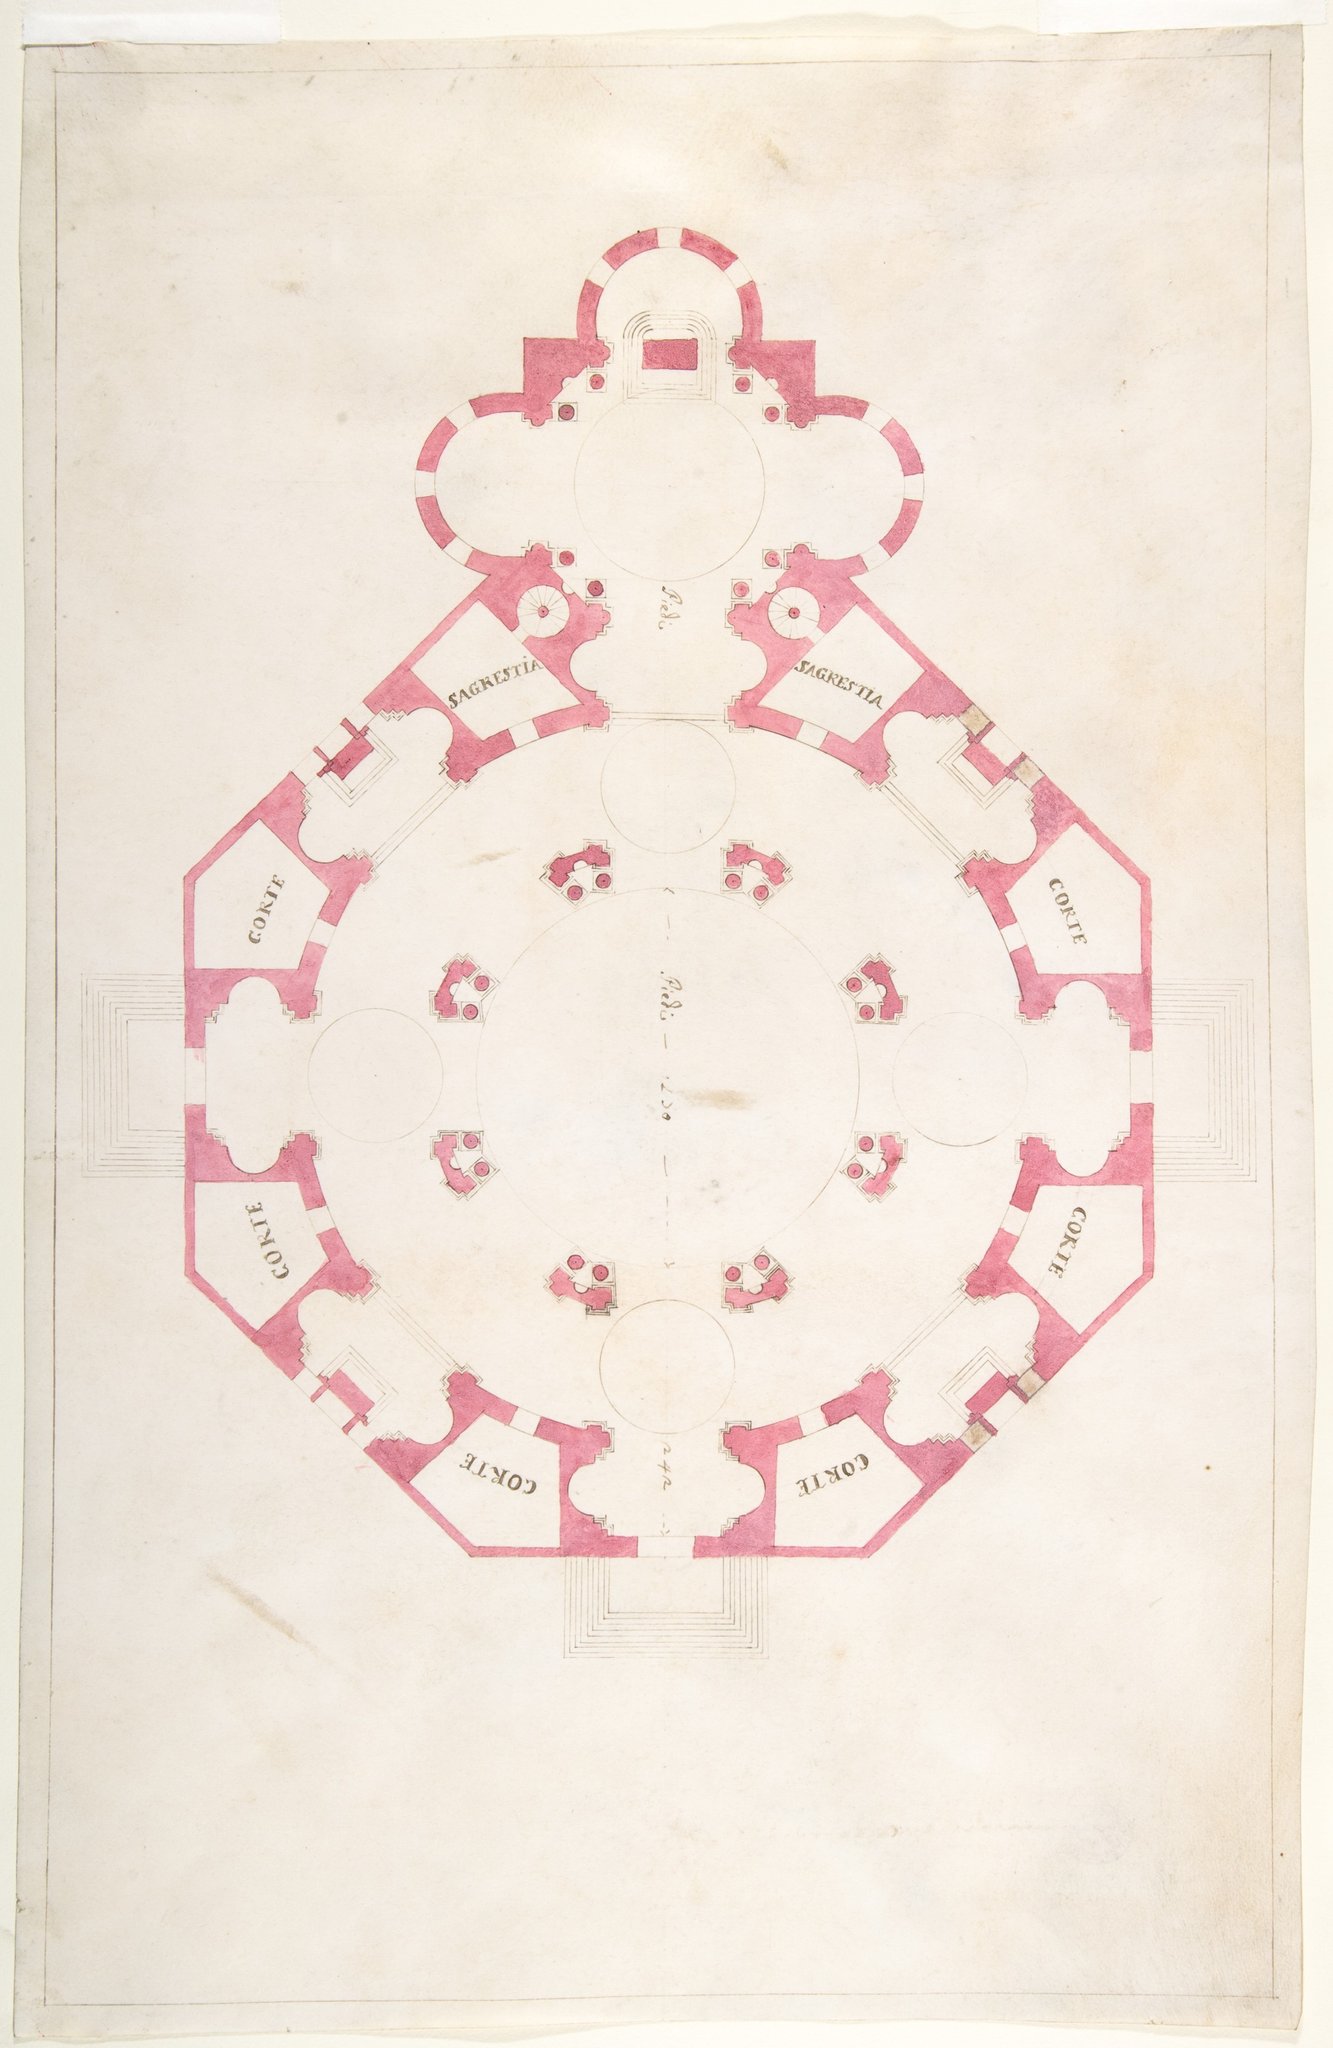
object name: drawing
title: Design for a Church with a Central Octagonal Plan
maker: anonymous, italian, 16th to early 17th century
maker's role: artist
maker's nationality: italian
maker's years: 1500-1640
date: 1570-1620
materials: ink, parchment, watercolor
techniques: brush, pen, wash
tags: architecture,churches